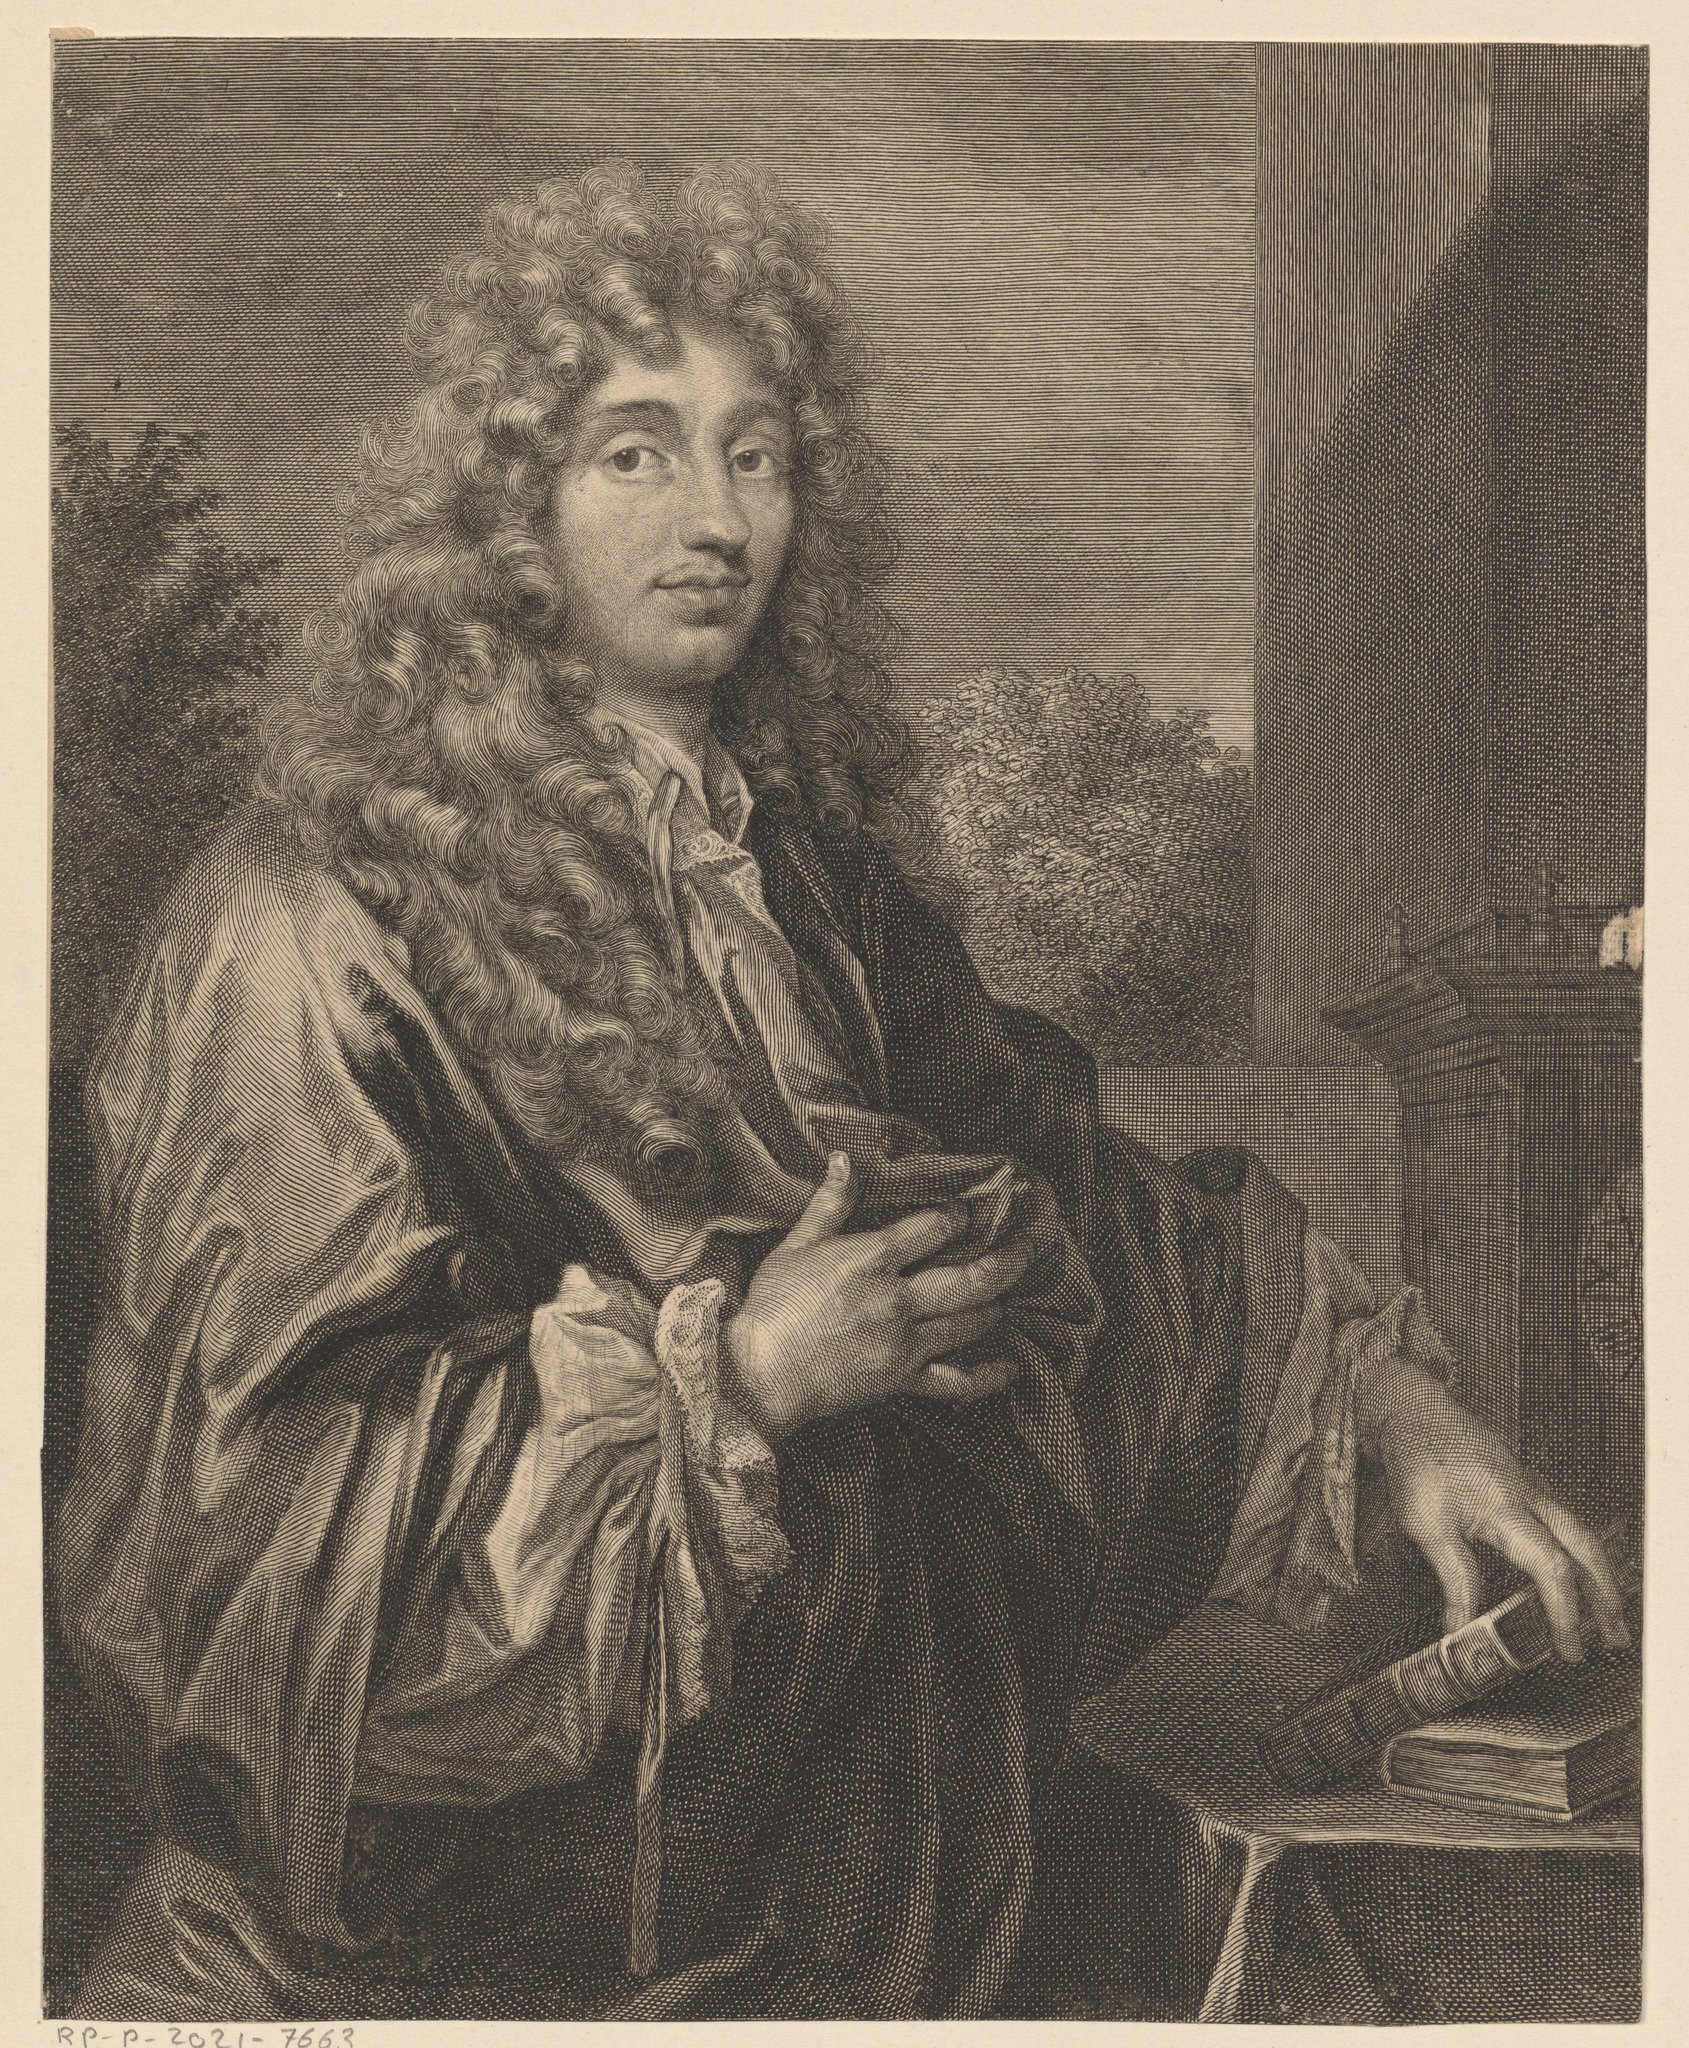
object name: print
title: Portret van Christiaan Huygens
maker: gerard edelinck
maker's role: print maker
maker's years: 1640-1707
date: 1650-1707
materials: paper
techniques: engraving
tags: the hague, draughtsman, physicist, christiaan huygens (ii), astronomy (and cosmography) (+ portrait of scholar, scientist), historical persons, mathematics (+ portrait of scholar, scientist)